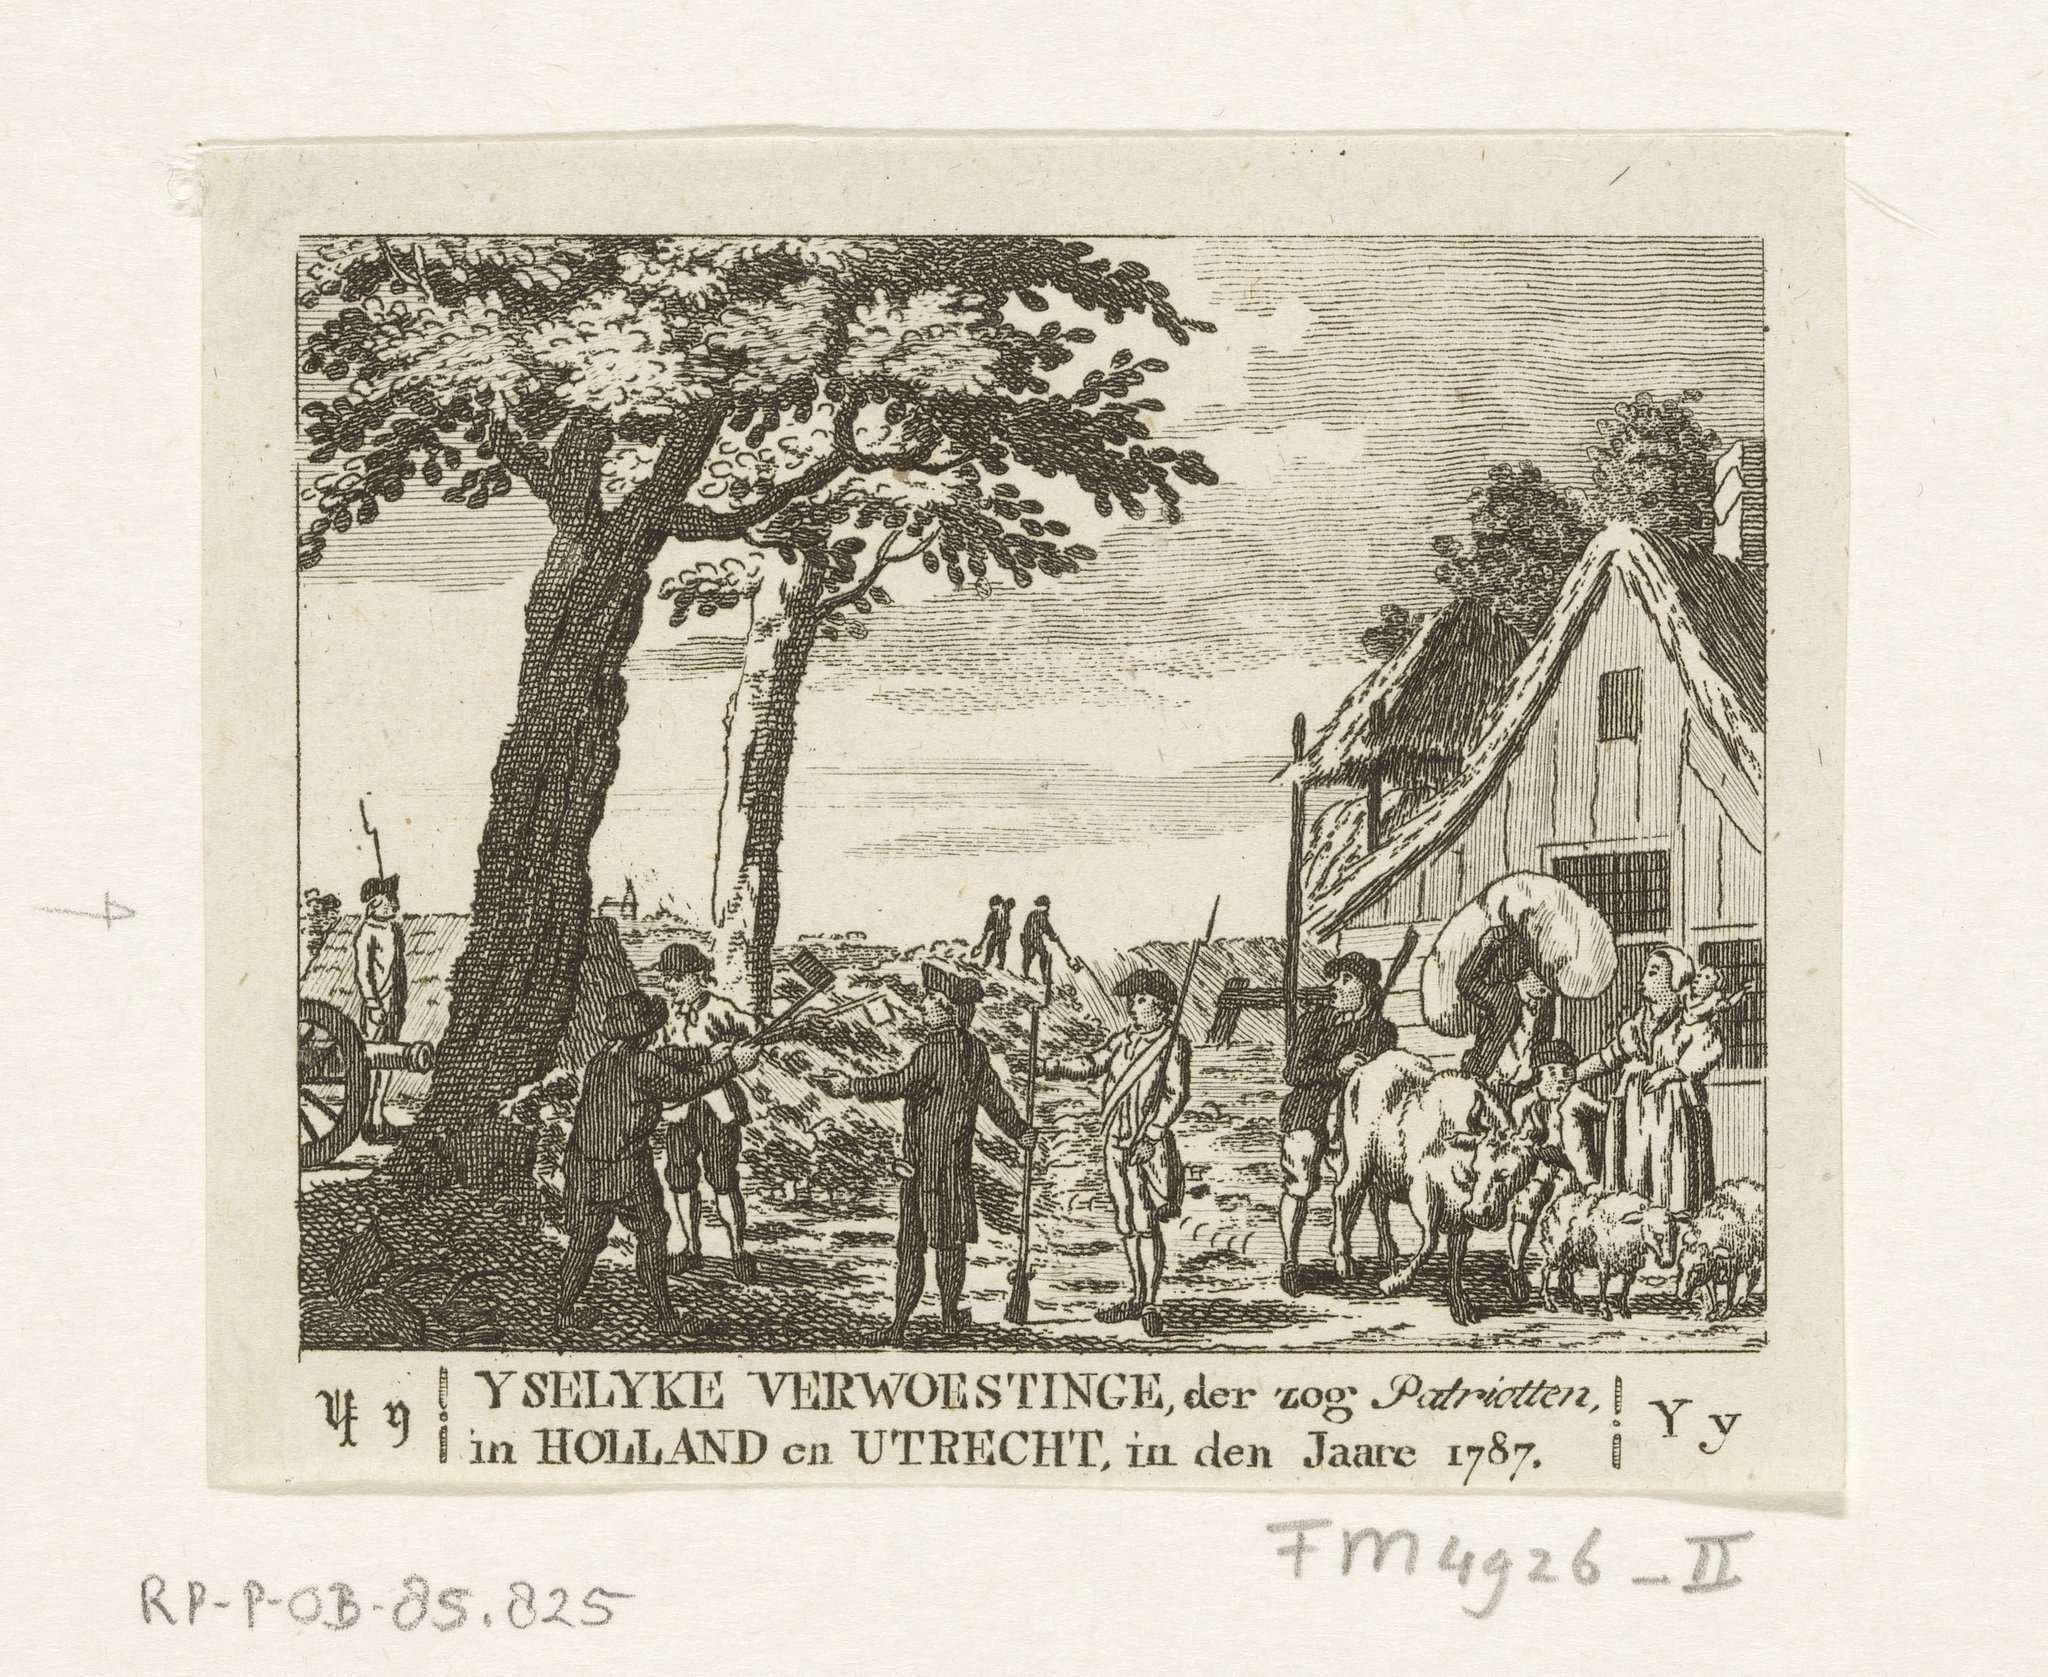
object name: print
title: Verwoestingen bij de uittocht van de Patriotten, 1787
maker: Anonymous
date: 1787-1790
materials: paper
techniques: engraving, etching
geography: northern netherlands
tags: plundering ~ soldiers (+ citizen soldiery, civil guard, citizen militia), utrecht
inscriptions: collector's mark: Lugt 2228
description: Verwoestingen en plunderingen aangericht door de patriotten tijdens hun uittocht uit Utrecht en Holland in september 1787, bij het naderen van de Pruisische troepen. Plaatje behorend bij de letter Y uit een ABC boek. Bij de prent behoort een tekstblaadje.